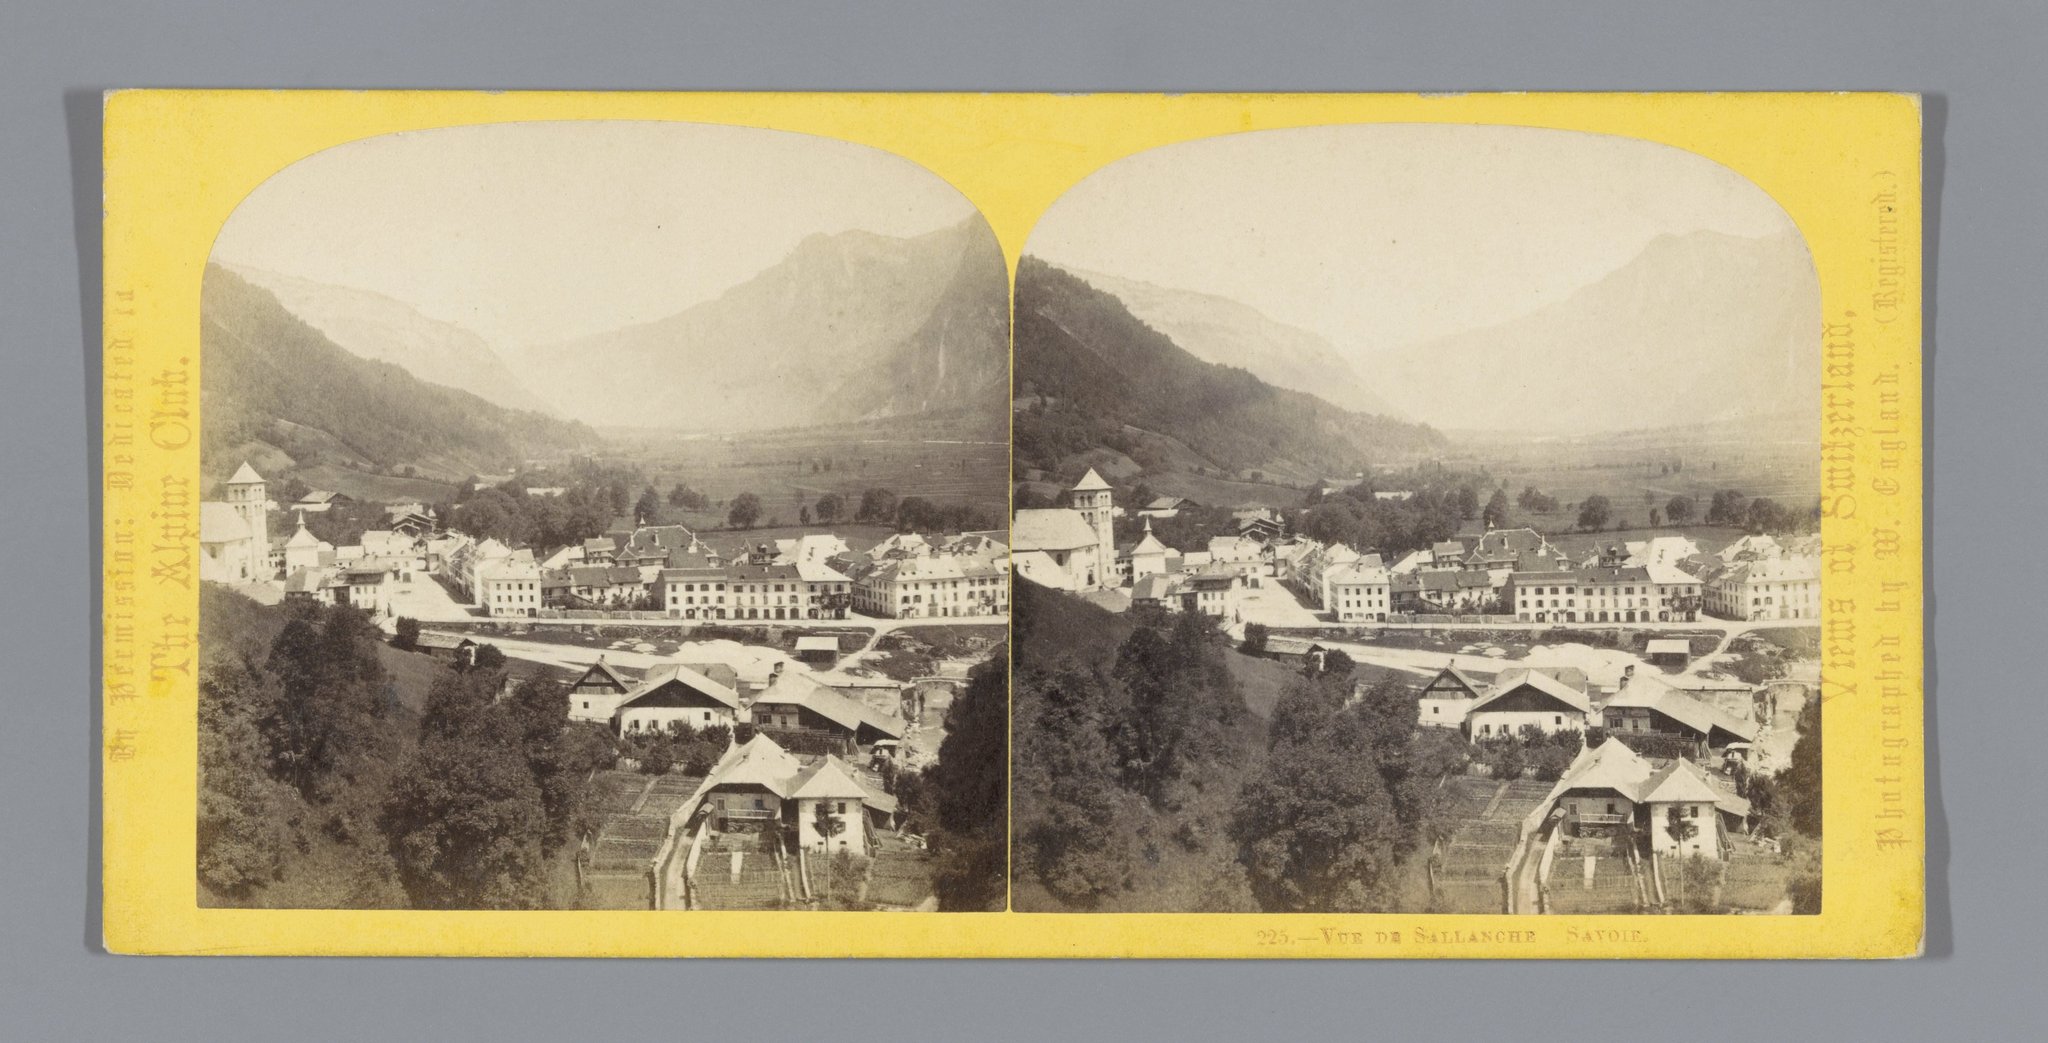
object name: stereograph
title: Gezicht op Sallanches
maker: william england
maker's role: fotograaf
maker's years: 1816-1896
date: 1850-1880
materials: cardboard, photographic support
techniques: albumen print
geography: haute-savoie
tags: city-view in general; 'veduta'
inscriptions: inscription: ‘Views of Switzerland, photographed by W. England. (Registered) Under the Special Patronage of the Alpine Club.’, number: ‘225.’